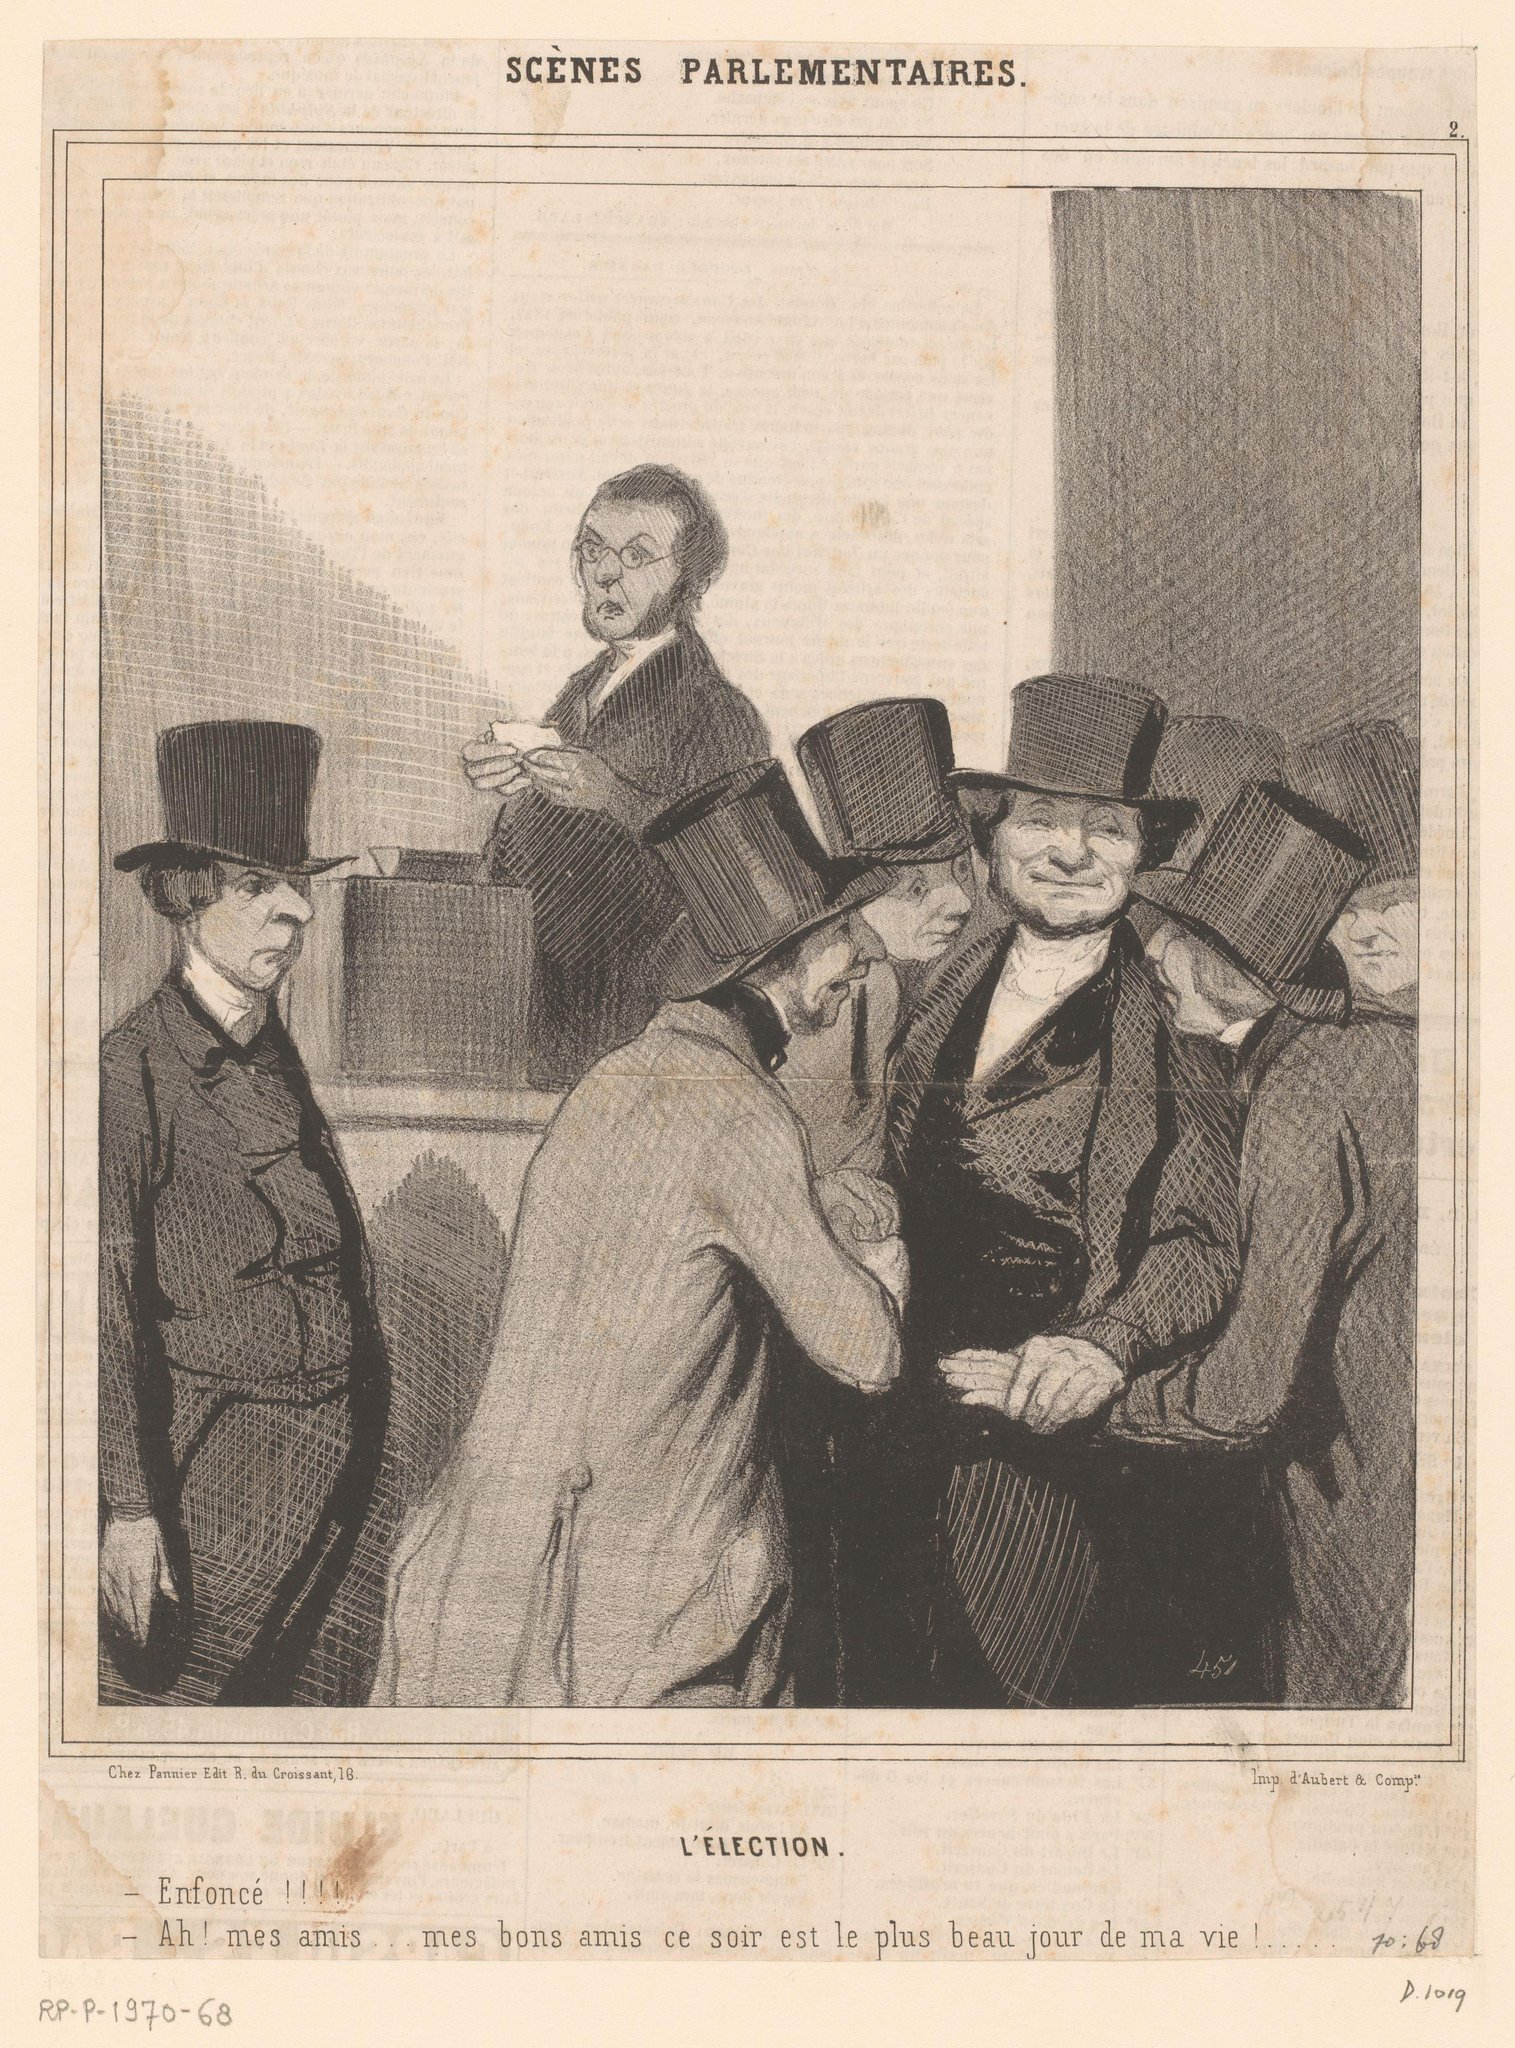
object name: cartoon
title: Scènes parlementaires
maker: honoré daumier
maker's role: draughtsman, painter, print maker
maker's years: 1808-1879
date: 1843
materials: paper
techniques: lithograph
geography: paris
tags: voting, election, caricatures (human types), political caricatures and satires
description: Prent gepubliceerd in: Le Charivari, Aubert: Parijs, 08-04-1843. Le Charivari was een humoristische krant met karikaturen en (politieke) cartoons.